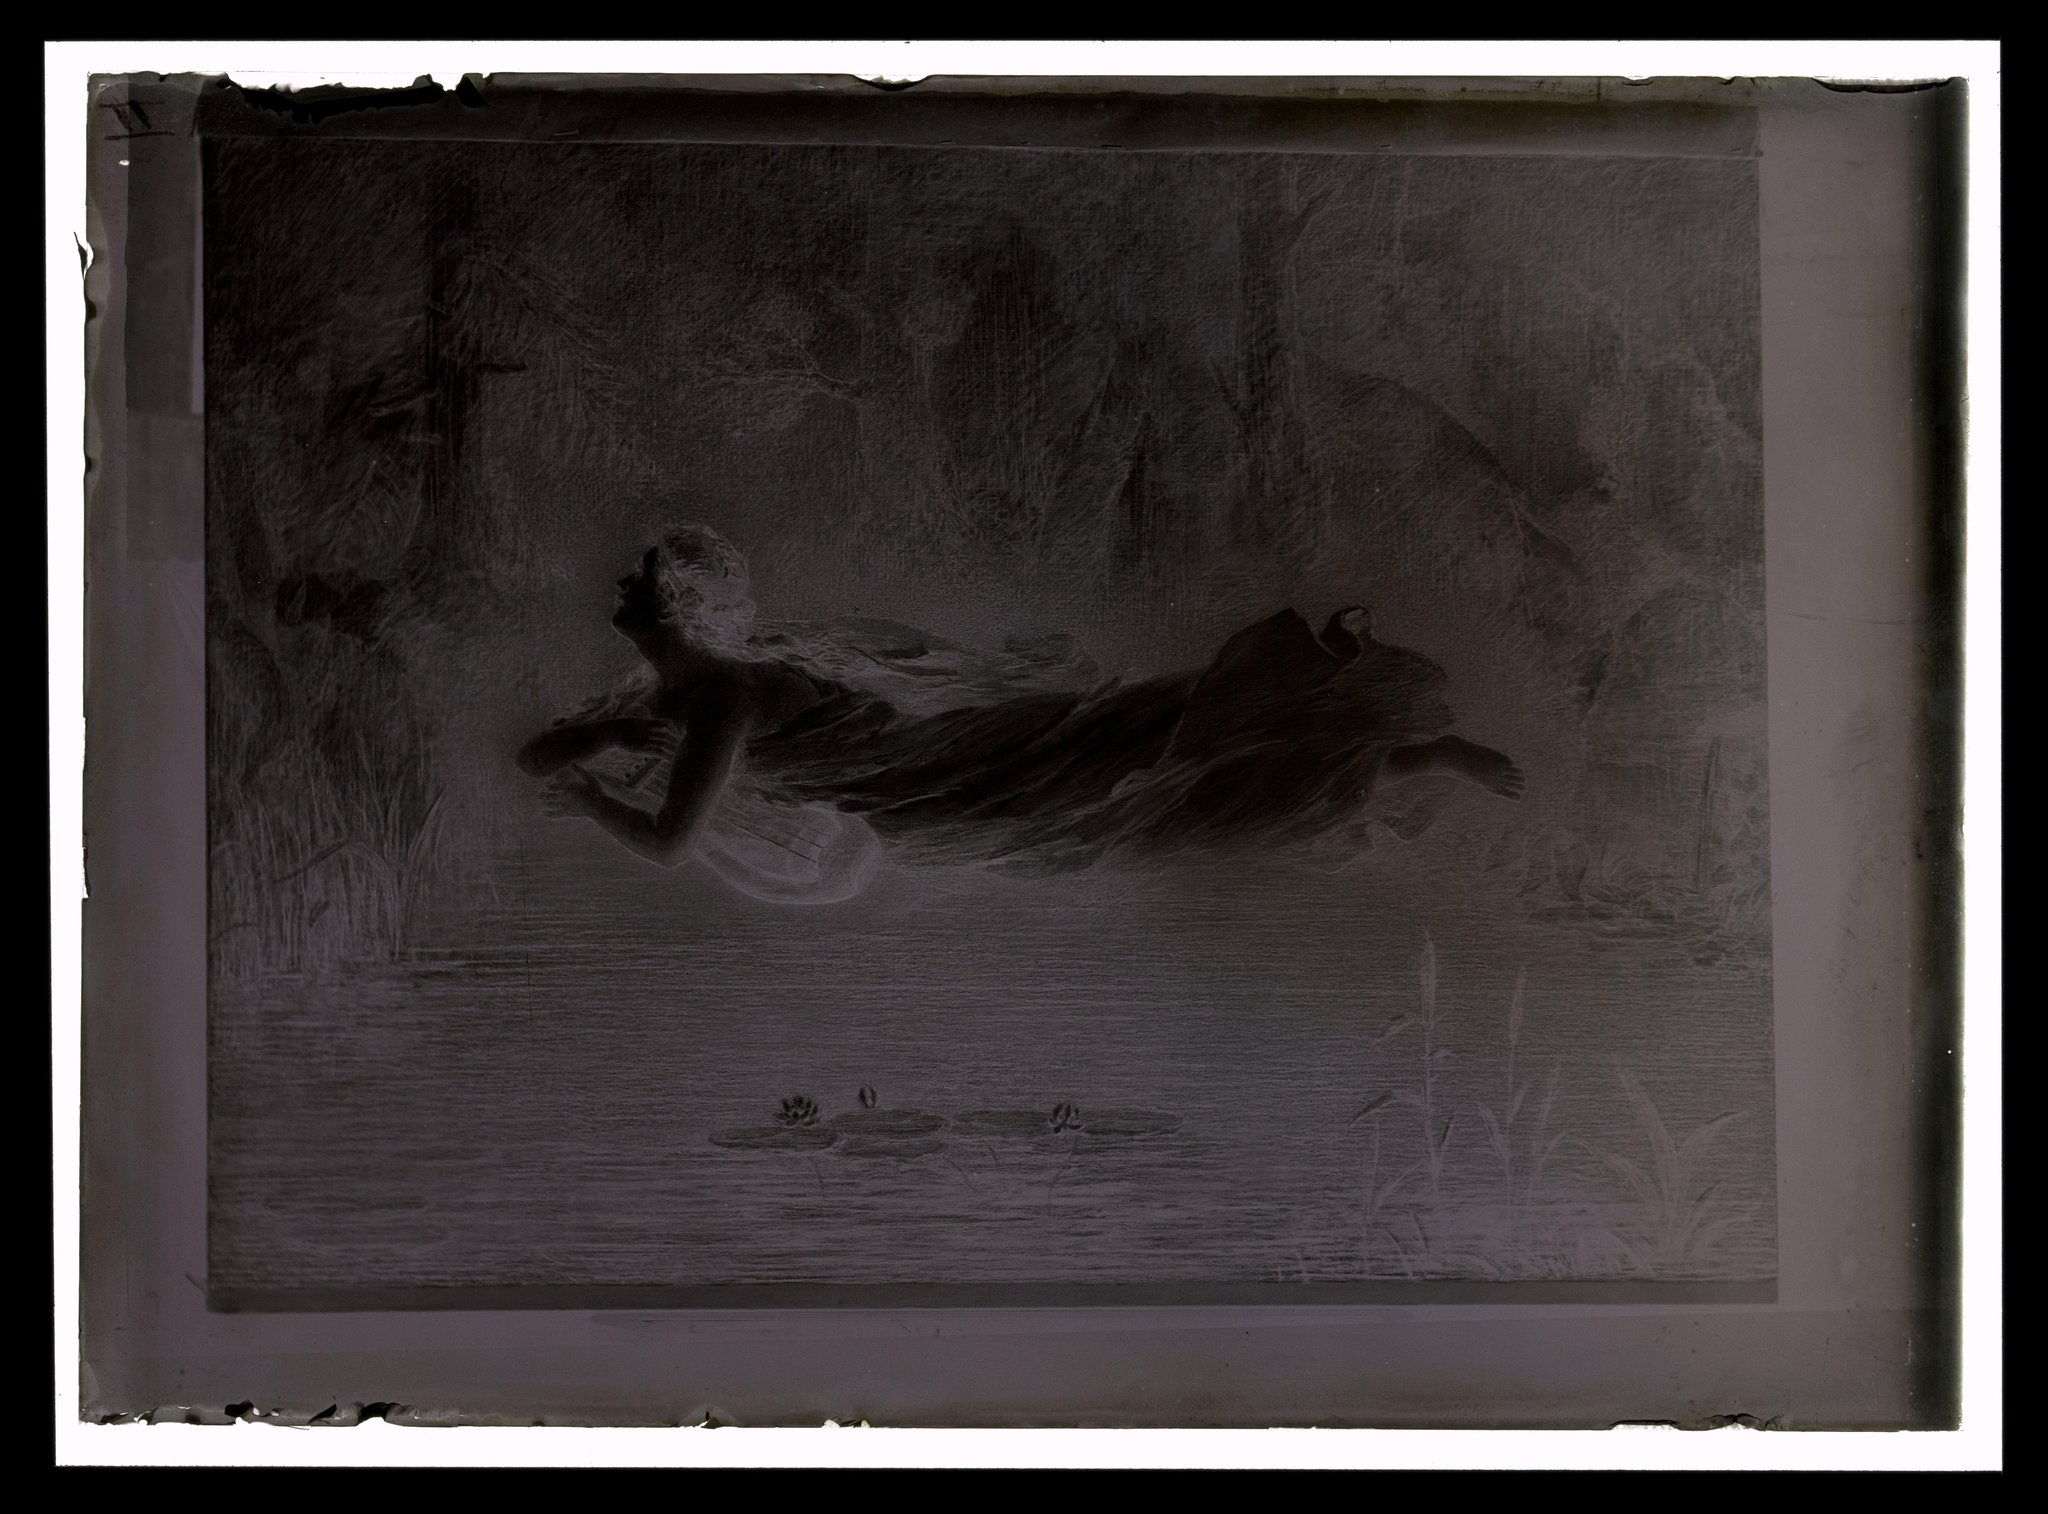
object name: glasnegatief, glasplaatnegatief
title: Fotoreproductie van een schilderij van een liggende vrouw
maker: laurens lodewijk kleijn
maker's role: draughtsman, painter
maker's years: 1826-1909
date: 1865-1900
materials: glass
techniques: collodion process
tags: adult woman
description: Onderdeel van een groep glasnegatieven uit de nalatenschap van de schilder Laurens Lodewijk Kleijn, met stillevens, portretten, zelfportretten en kunstreproducties.